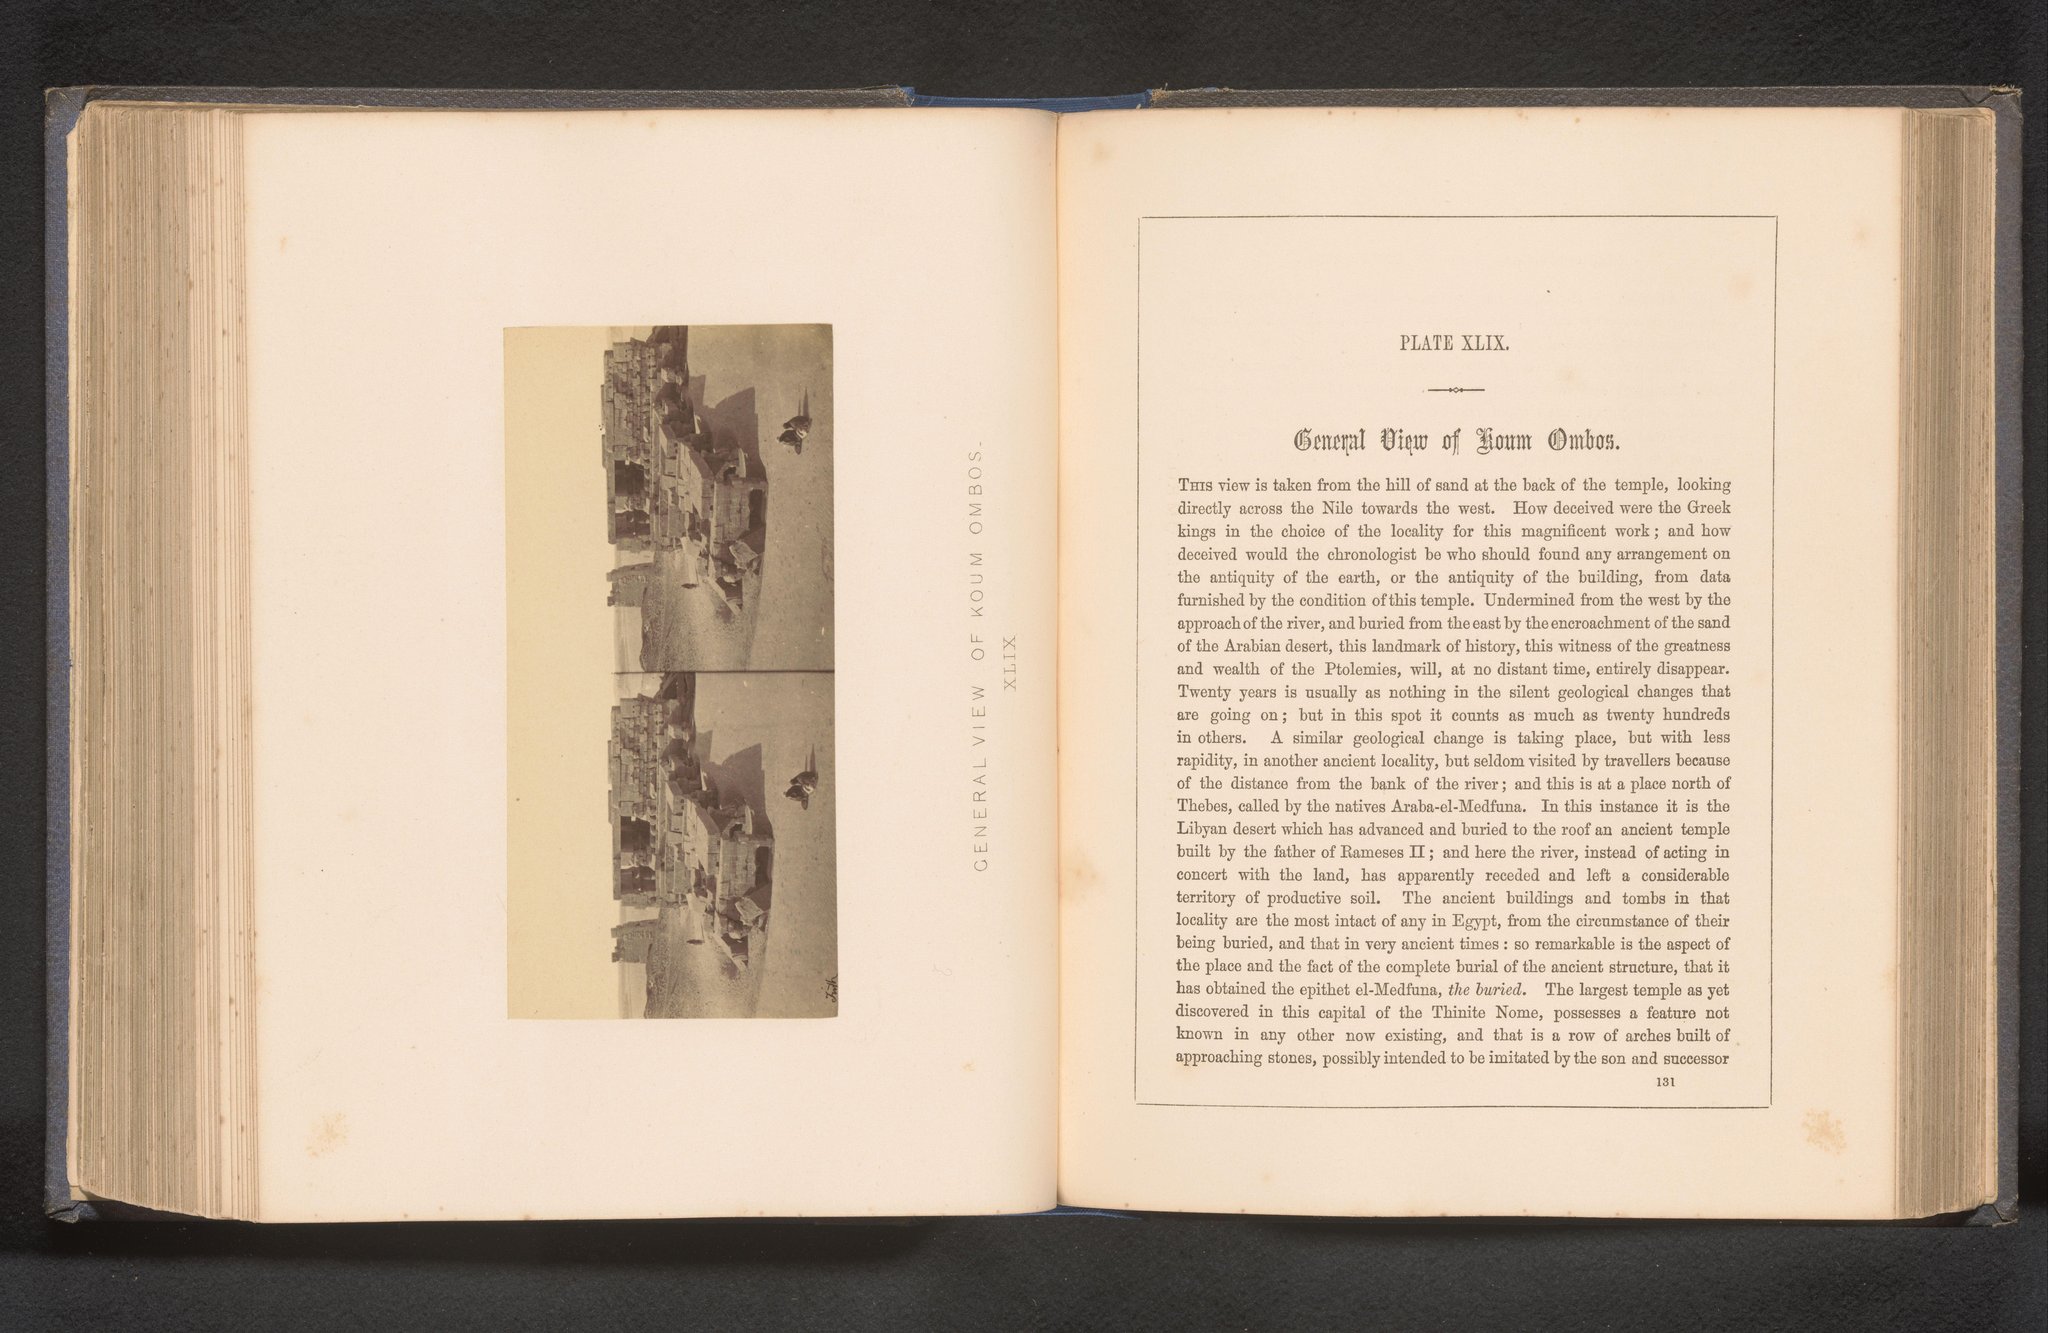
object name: stereograph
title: Gezicht op Kom Ombo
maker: francis frith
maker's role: publisher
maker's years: 1822-1898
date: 1857-1862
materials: photographic support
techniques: albumen print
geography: kom ombo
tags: temple, shrine ~ egyptian religion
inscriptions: name: ‘Frith’, number: ‘XLIX’